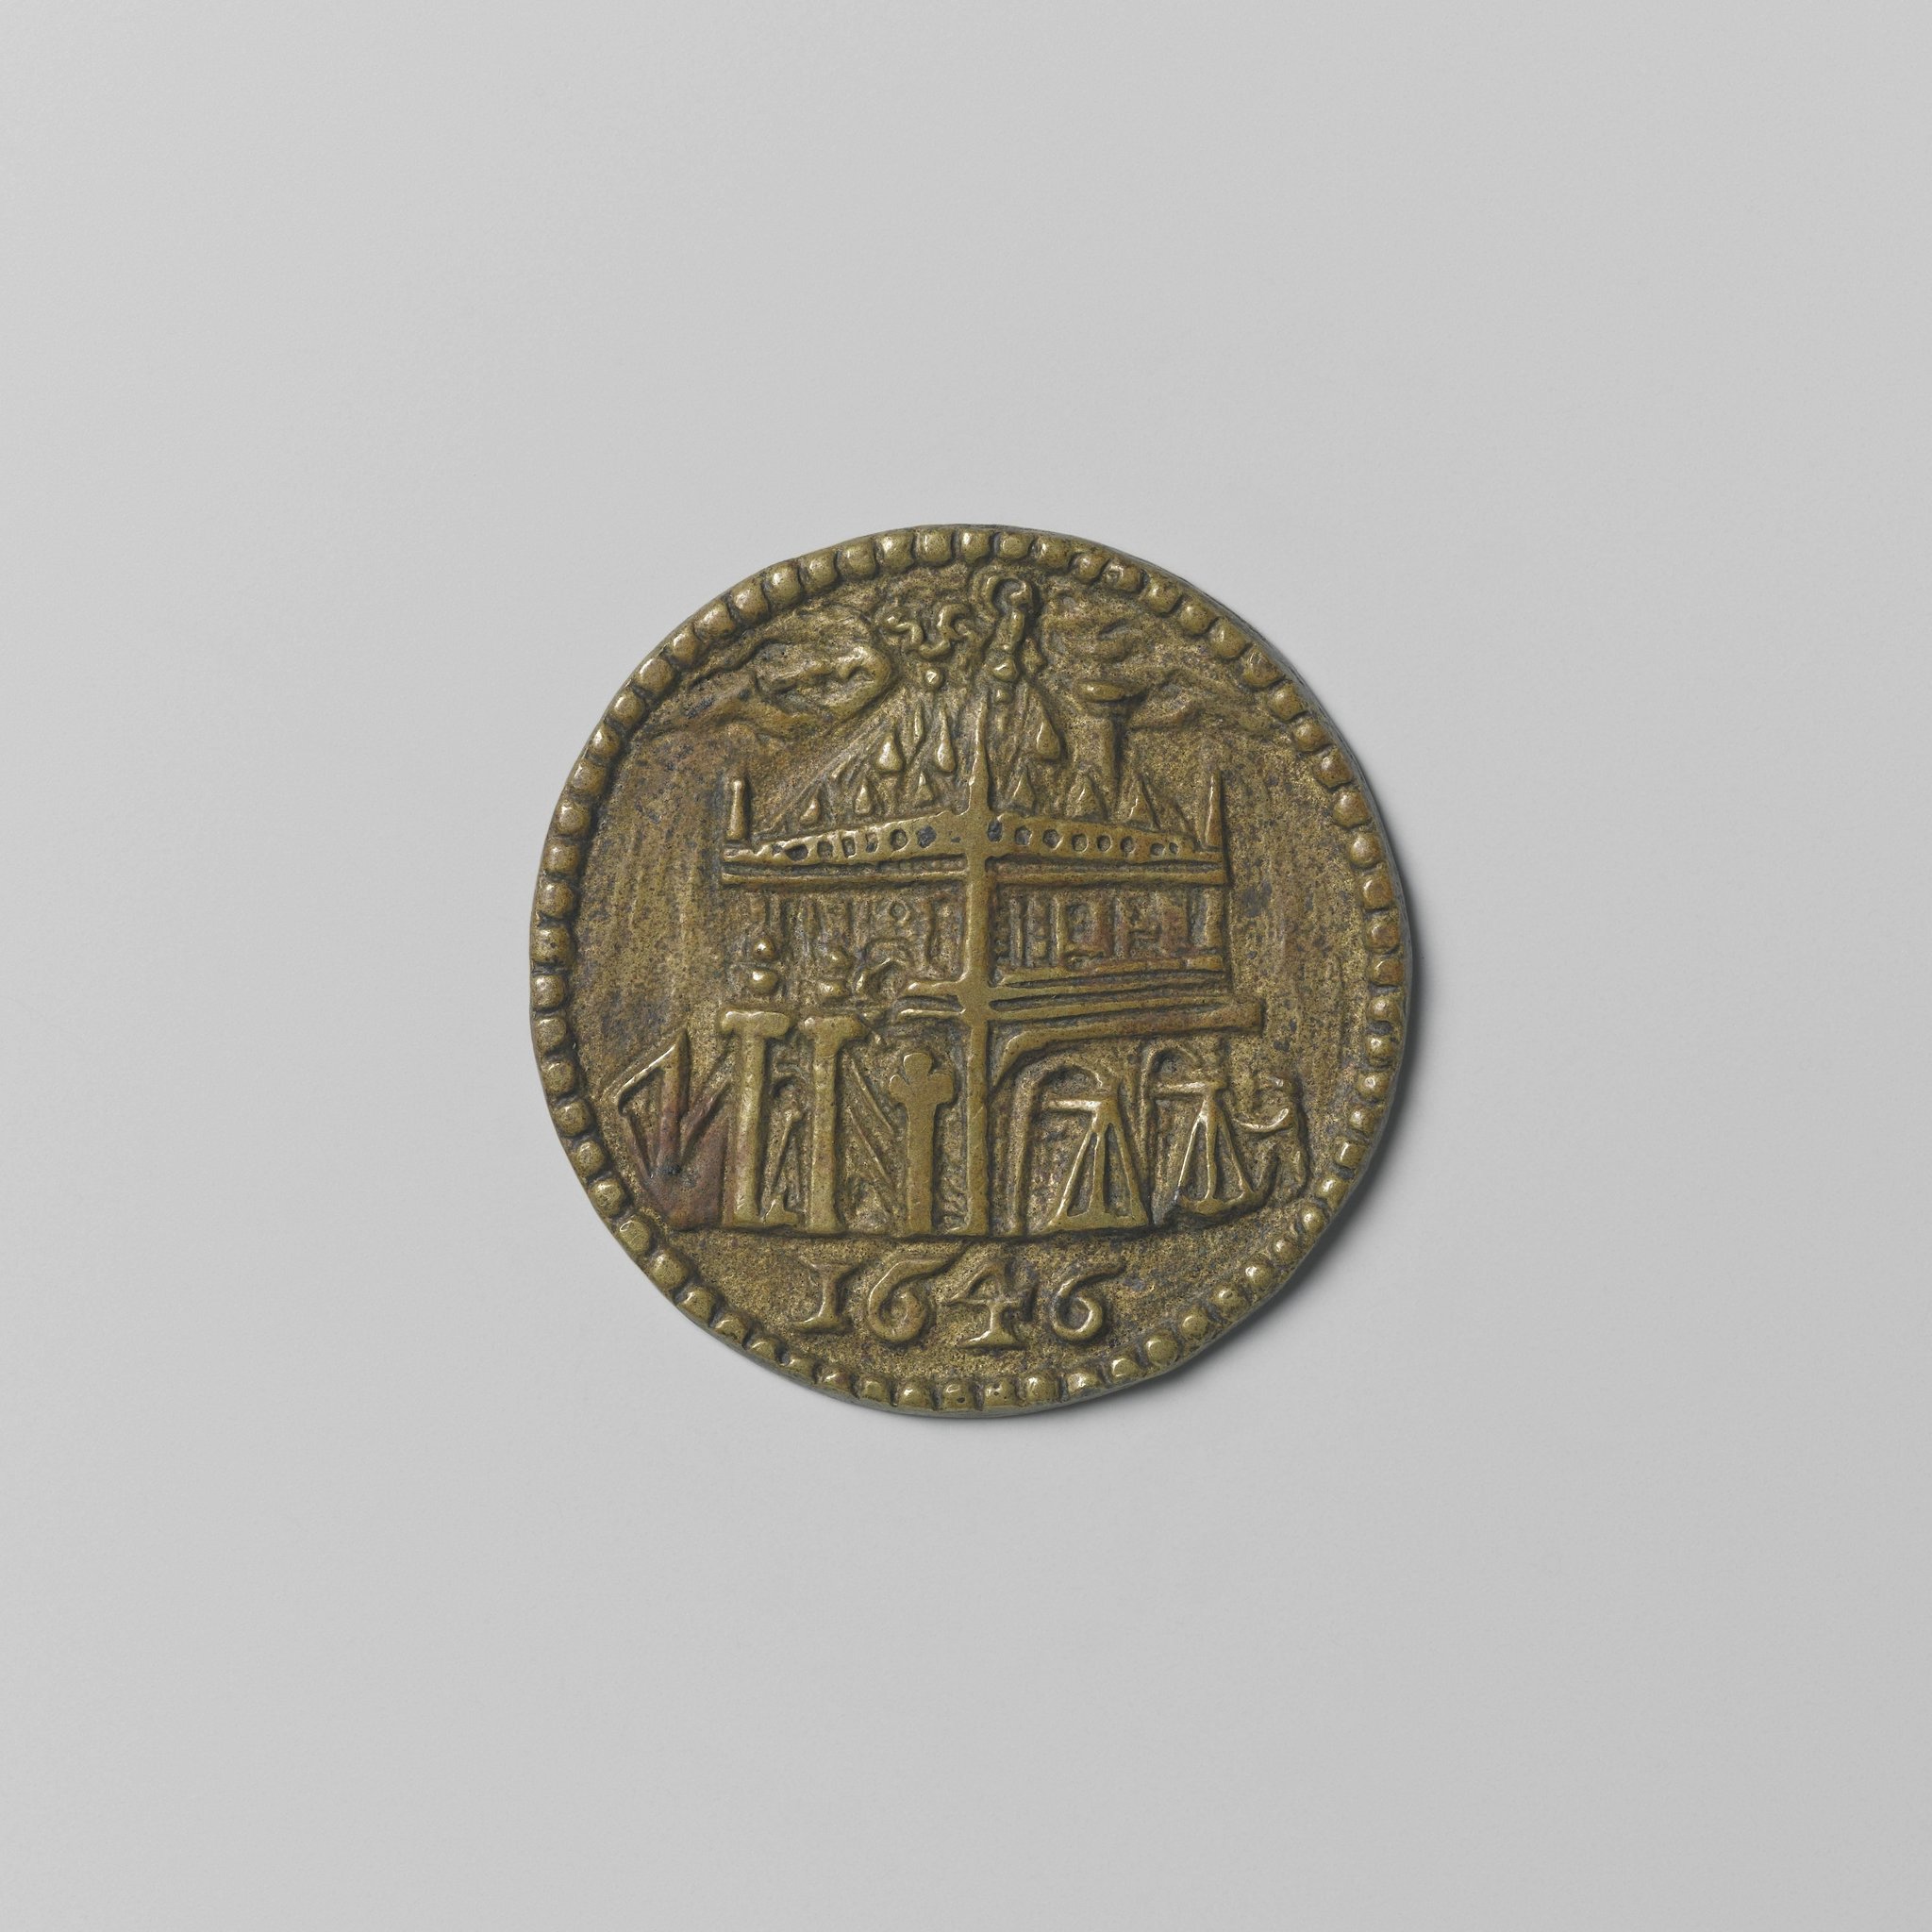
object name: medal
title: Waagdragersgilde van Amsterdam, gildepenning van de vrijluiden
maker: Anonymous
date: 1646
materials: brass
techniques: casting, engraving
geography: amsterdam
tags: amsterdam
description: Eenzijdige messing penning. Voorzijde: gezicht op Waaggebouw te Amsterdam boven jaartal. Keerzijde: blanco